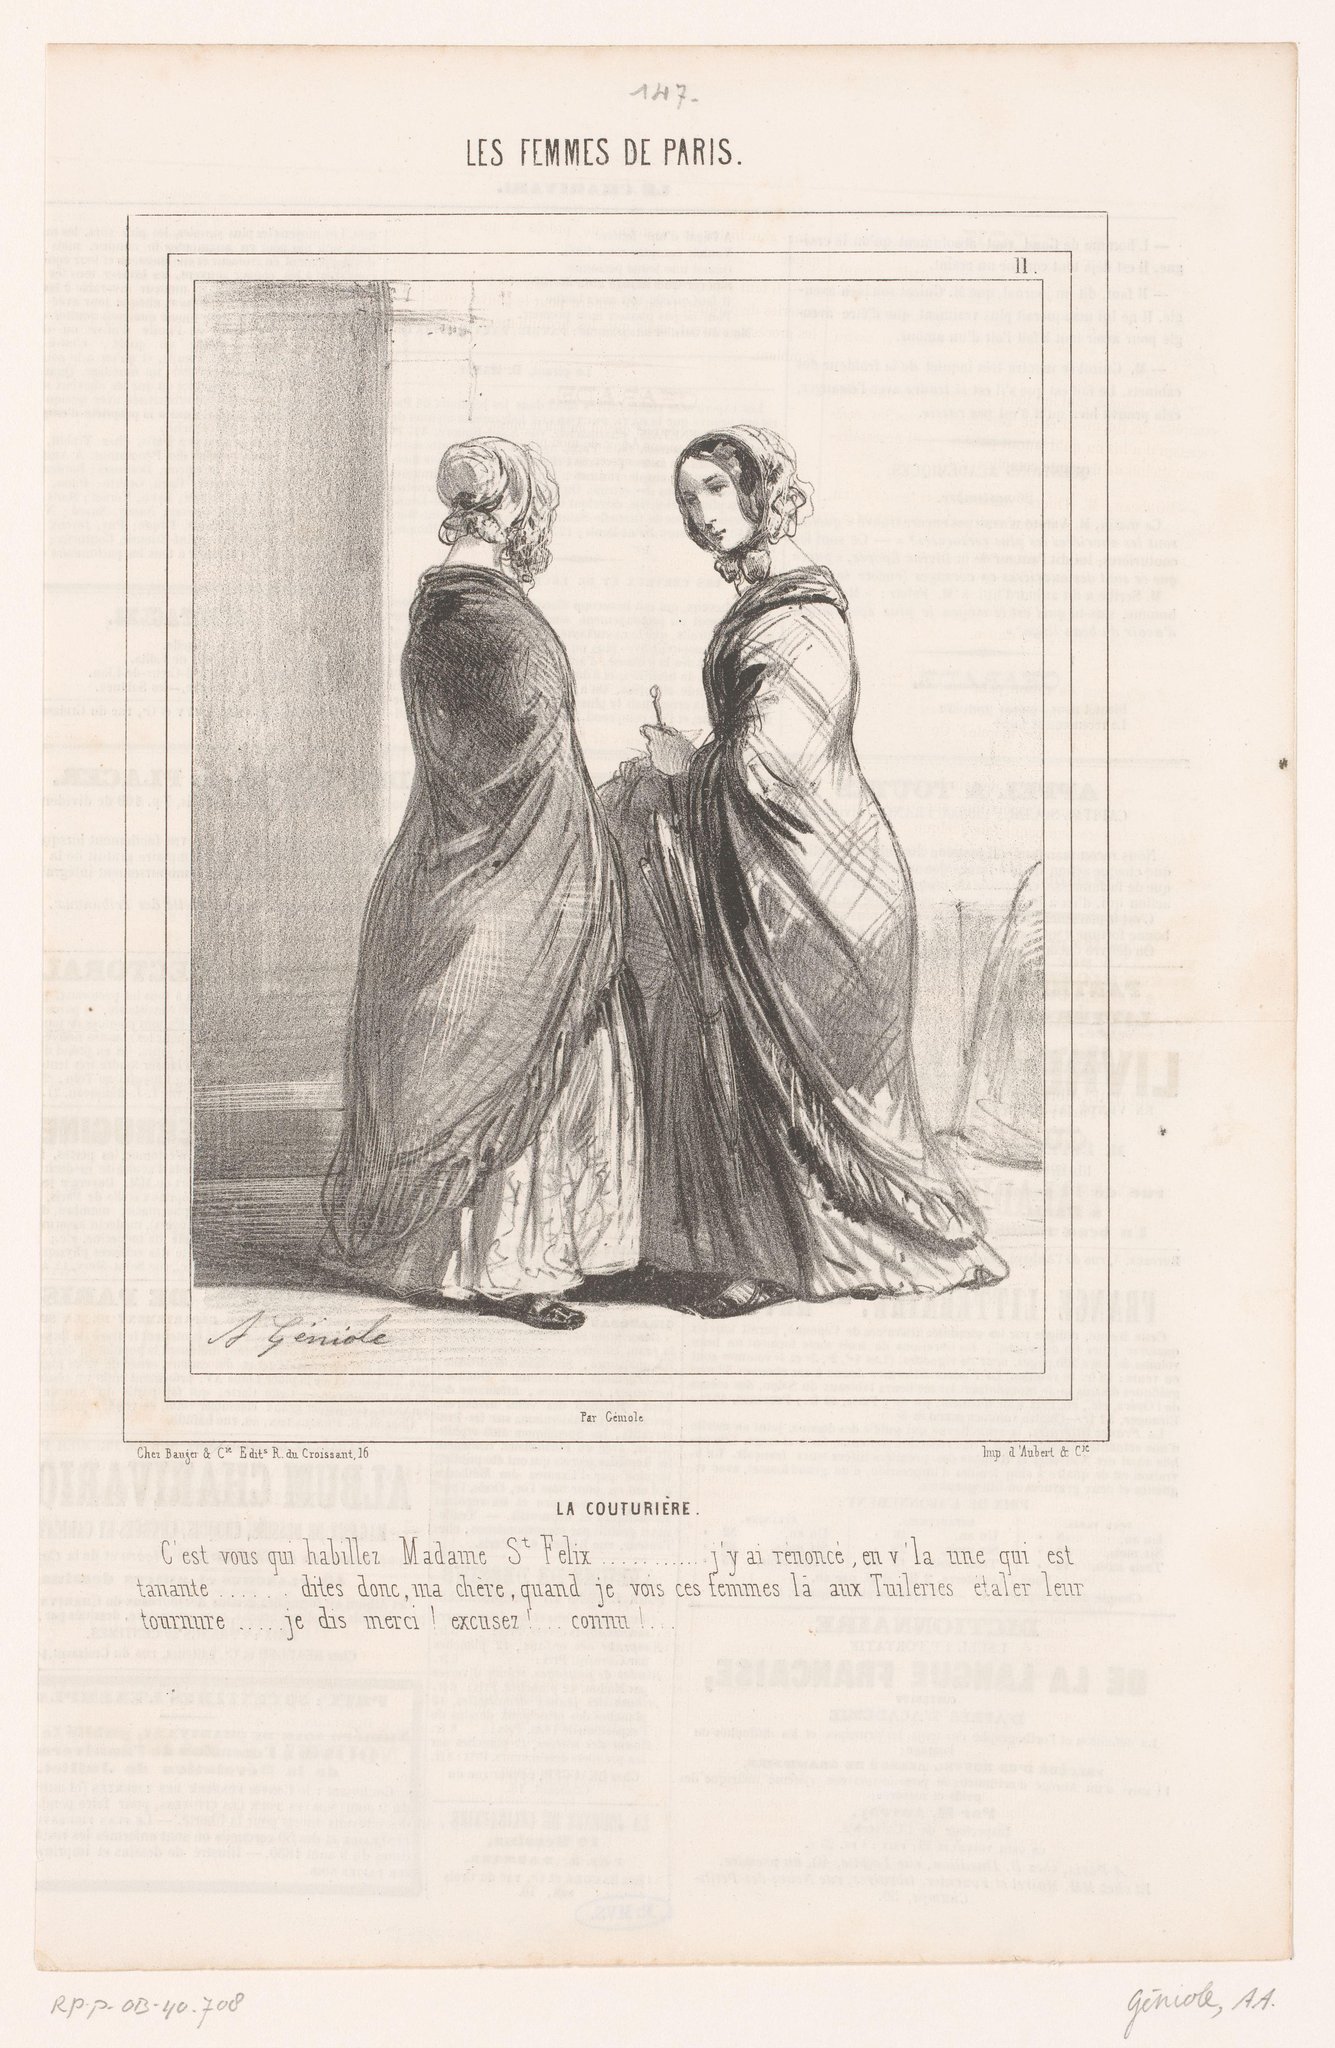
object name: cartoon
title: Les femmes de Paris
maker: alfred andré géniole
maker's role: print maker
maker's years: 1813-1861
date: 1842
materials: paper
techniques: lithograph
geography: paris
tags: conversation, dialogue; conversation piece, tailor, dressmaker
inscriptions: collector's mark: Lugt 2228a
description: Prent gebruikt voor: Le Charivari, 1842.